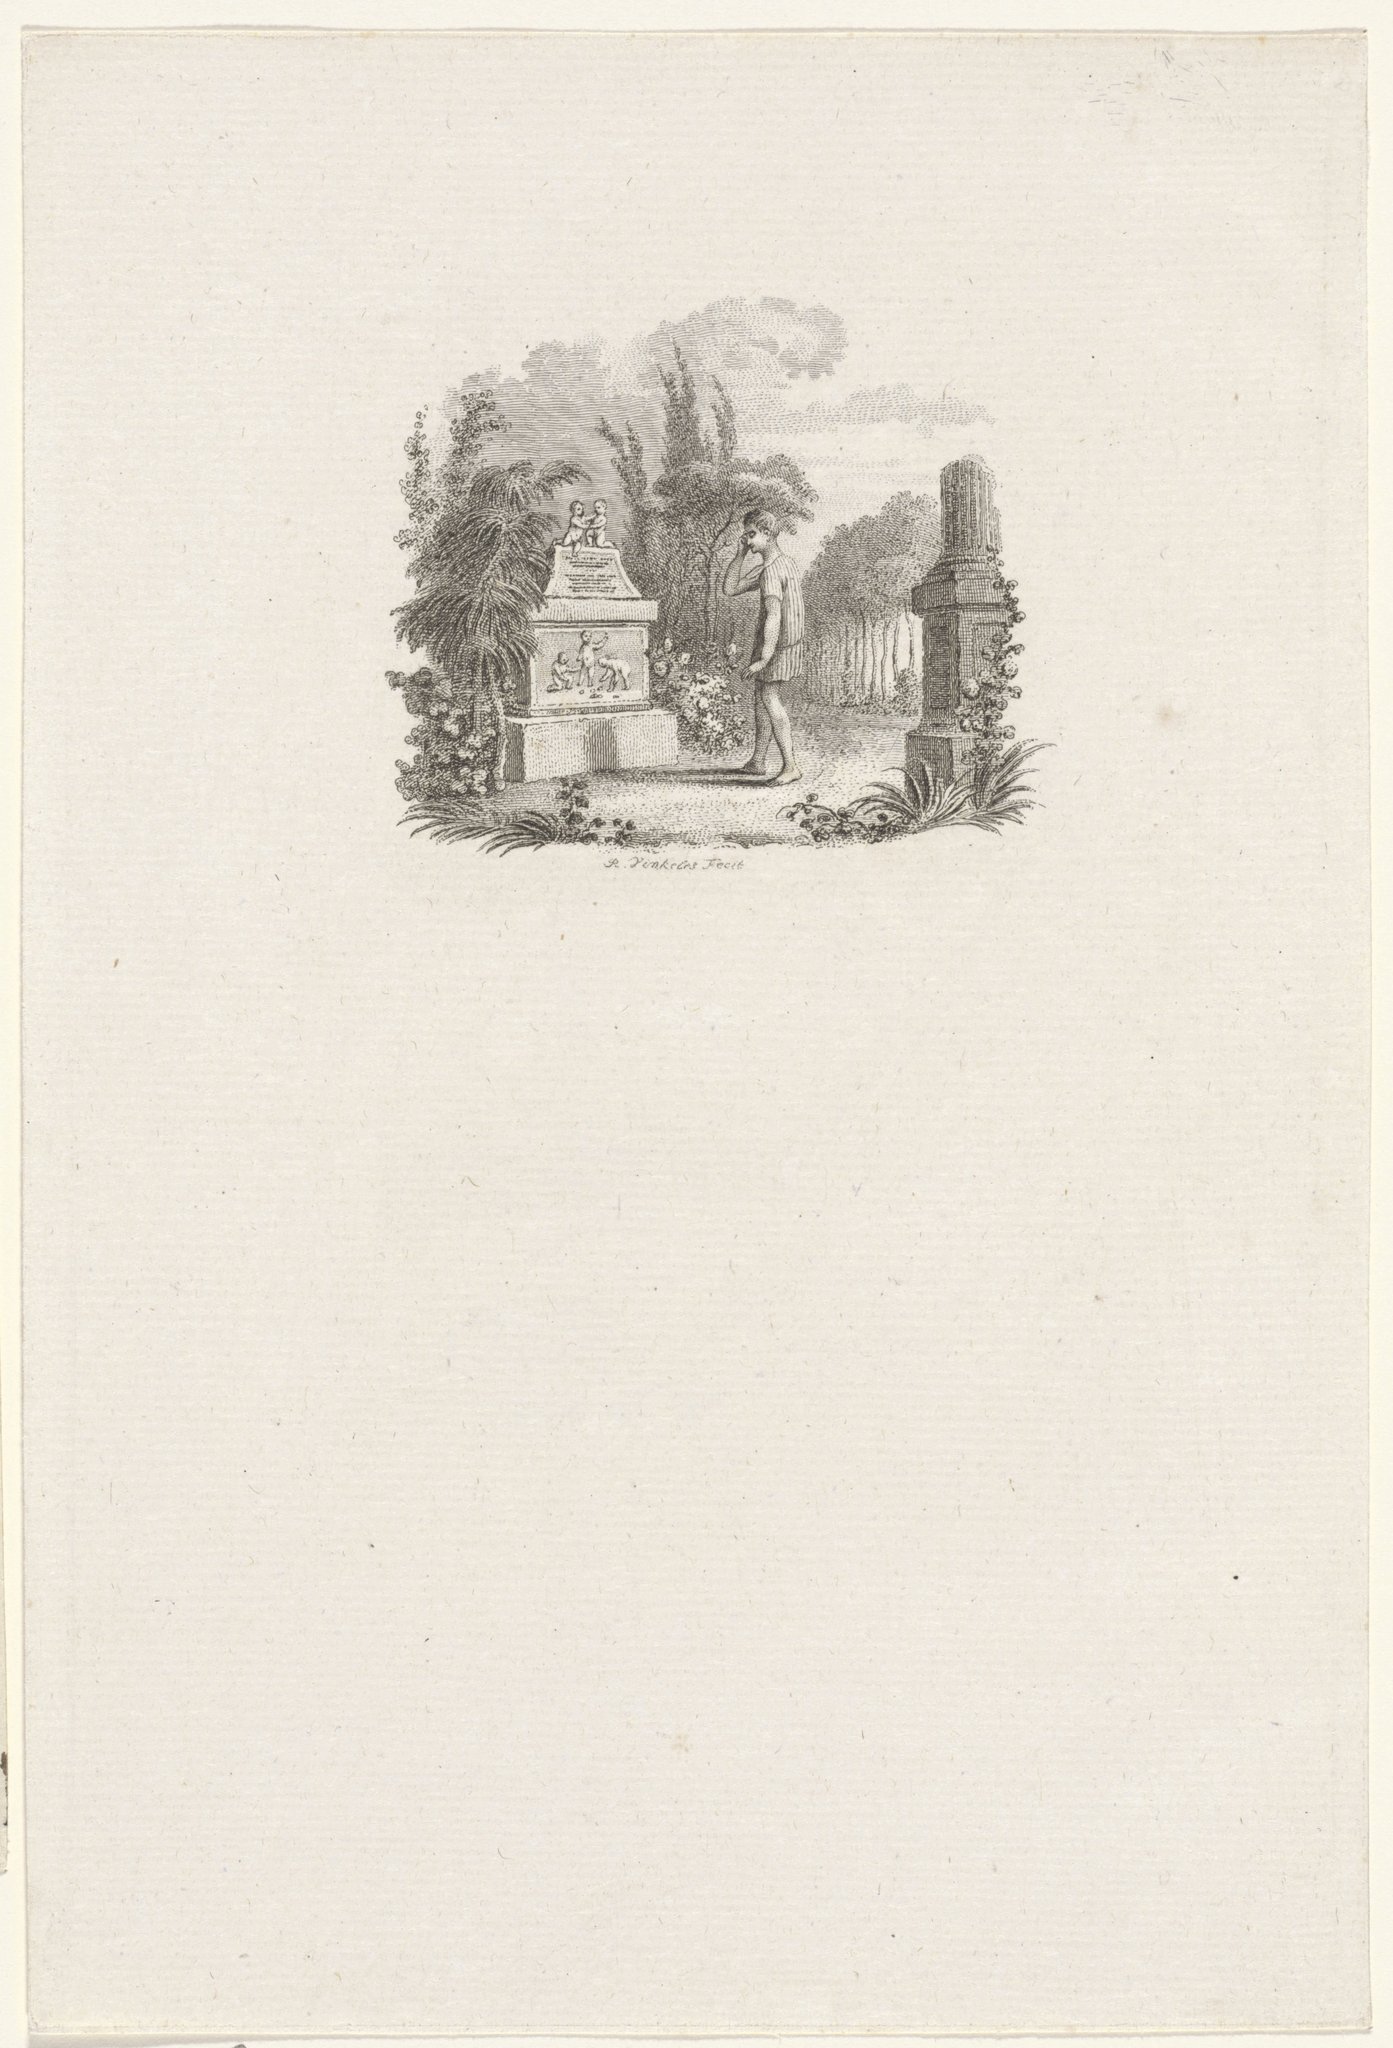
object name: print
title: Jonge man bij een grafmonument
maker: reinier vinkeles (i)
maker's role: draughtsman, print maker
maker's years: 1741-1816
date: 1751-1816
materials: paper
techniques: engraving, etching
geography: amsterdam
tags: grave, tomb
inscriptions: collector's mark: Lugt 2228